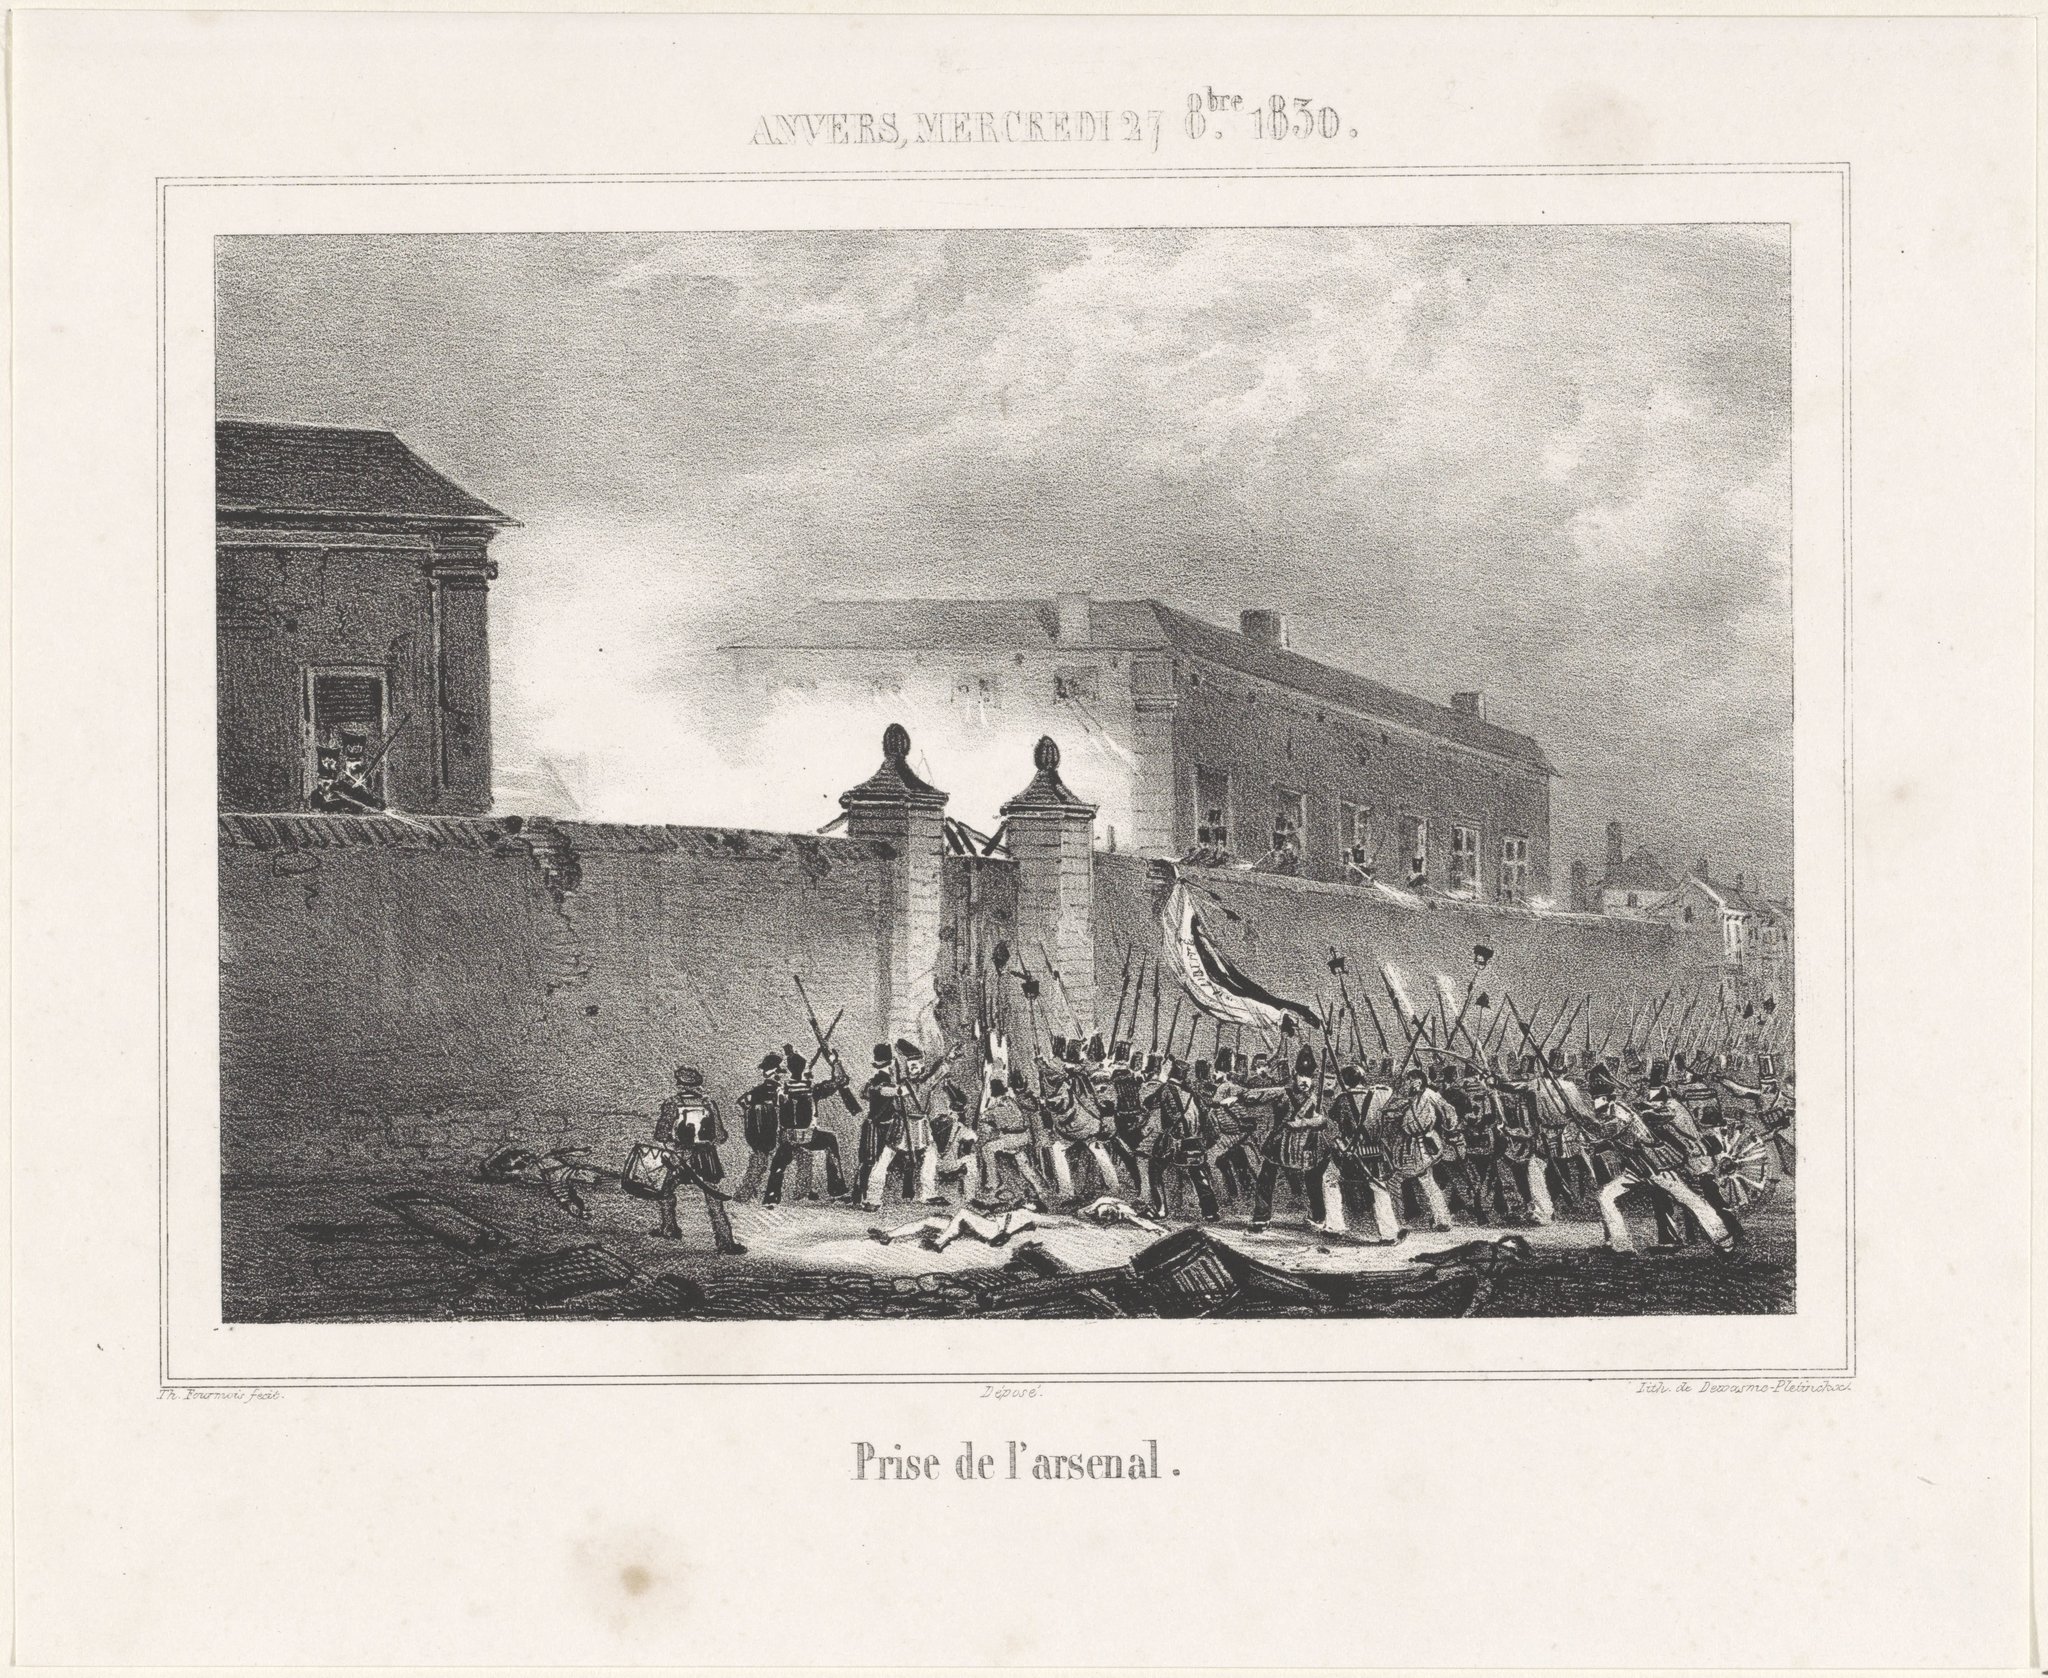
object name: print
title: Evénemens de Bruxelles, Anvers (...) (1831)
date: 1830-1831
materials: paper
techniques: lithograph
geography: brussels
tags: street-fights, riots, ammunition store, arsenal, antwerp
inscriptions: collector's mark: Lugt 2228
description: Belgische opstandelingen bestormen en veroveren het arsenaal in Antwerpen, 27 oktober 1830. Onderdeel van een recueil met platen over de gebeurtenissen tijdens de Belgische Revolutie in Brussel, Antwerpen en andere steden in de periode 25 augustus 1830 tot 27 maart 1831.